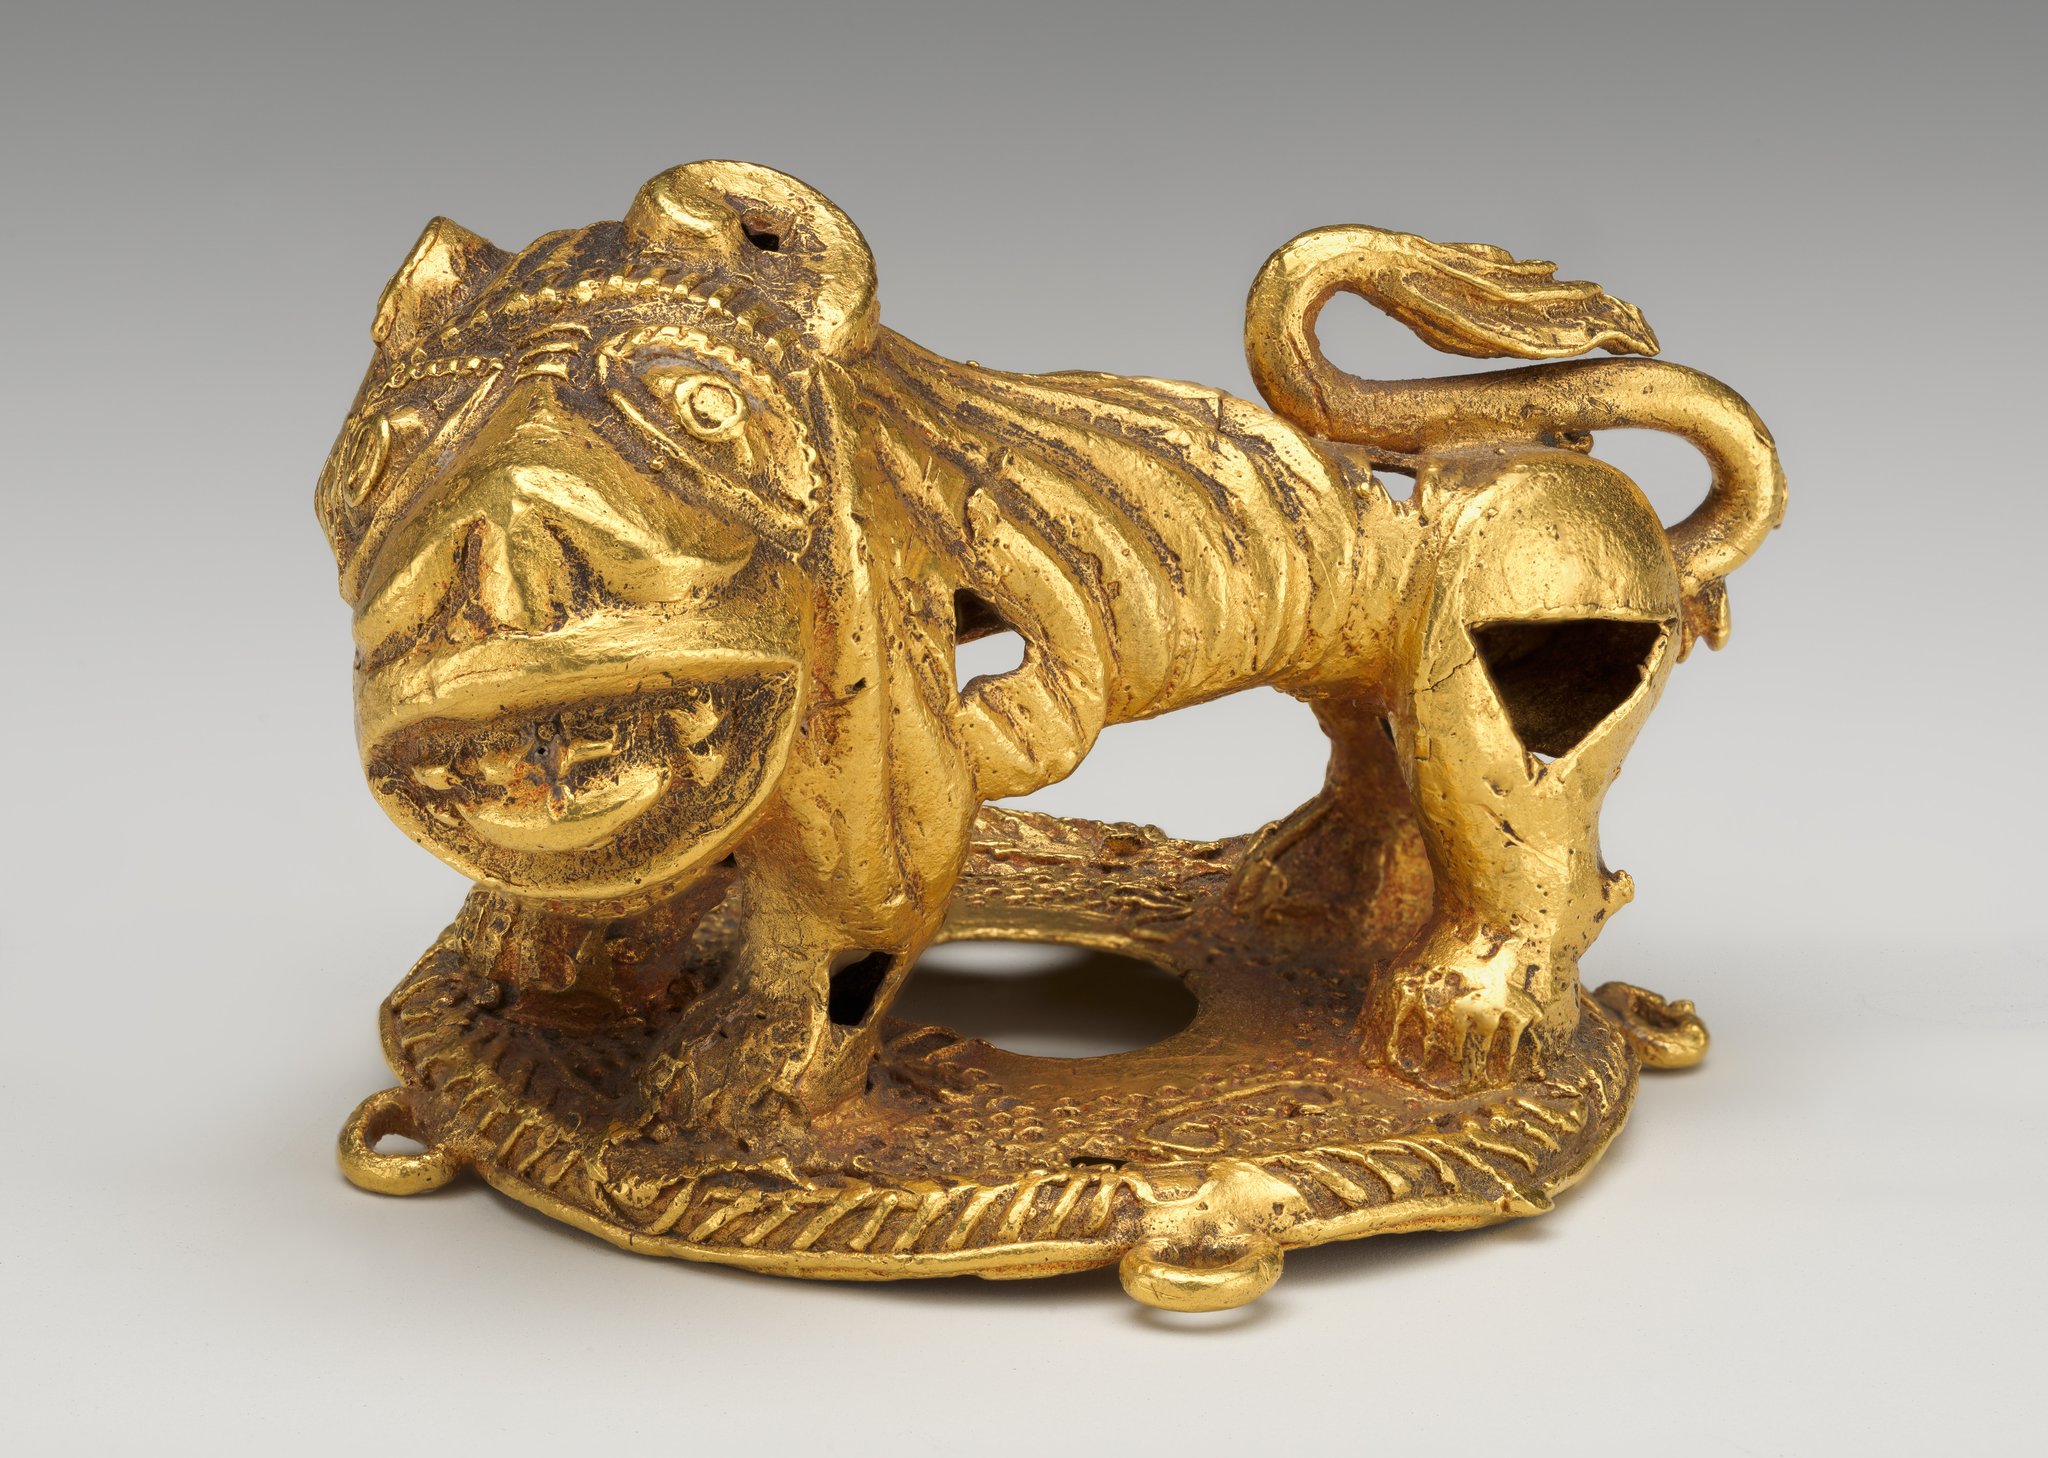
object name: ornament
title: Lion Ornament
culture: akan peoples, asante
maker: asante-akan artist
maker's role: artist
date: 1801-1900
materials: gold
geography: ghana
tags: lions